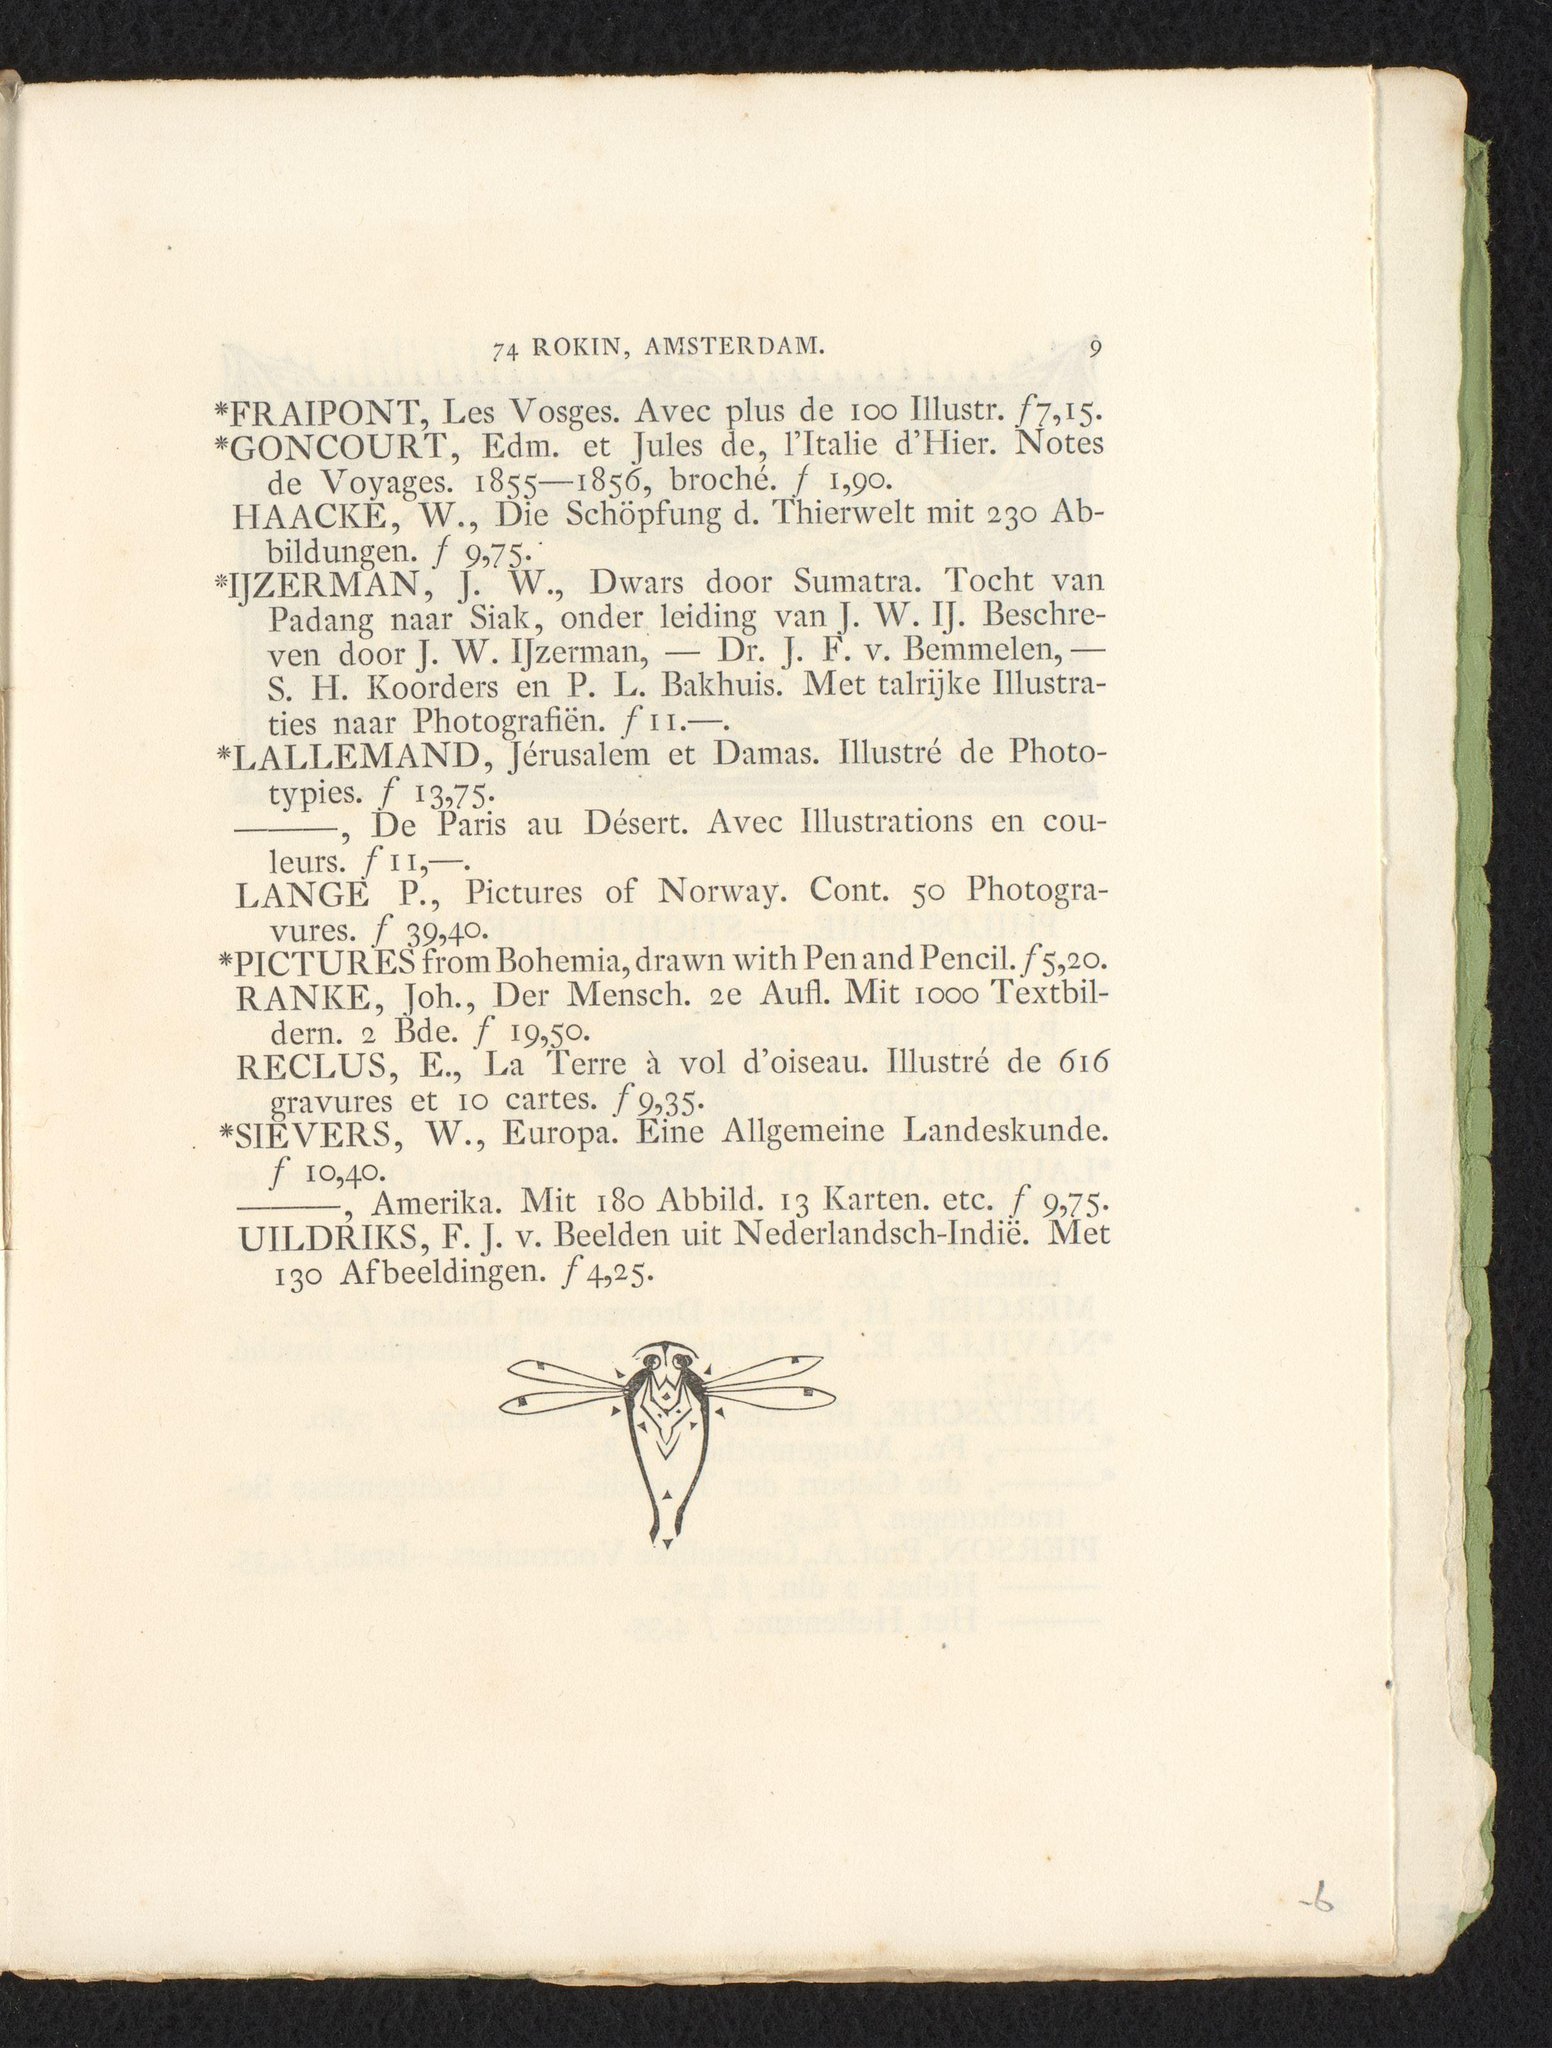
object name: book illustration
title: Sluitvignet met twee libellen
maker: gerrit willem dijsselhof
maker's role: designer, draughtsman, print maker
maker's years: 1866-1924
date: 1893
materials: paper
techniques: letterpress printing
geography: amsterdam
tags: insects: dragon-fly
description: Prent uit: Catalogus van handboeken, pracht- en plaatwerken, dicht- en prozabundels en kinderliteratuur (...). Amsterdam: Scheltema & Holkema's Boekhandel, 1894, p. 9. Deze prent werd origineel ontworpen voor: Crane, Walter. Kunst en samenleving. [Vertaald uit het Engels door] Jan Veth. Amsterdam: Scheltema & Holkema's Boekhandel, 1894 [1893], p. 171.